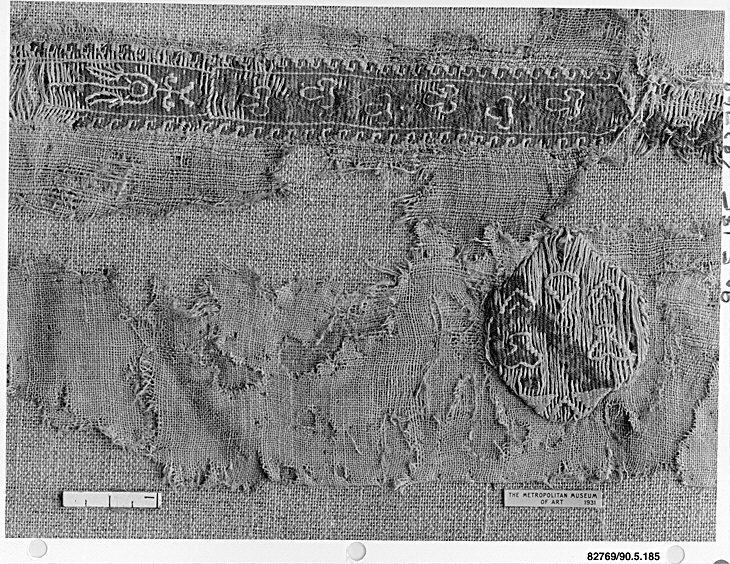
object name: textile fragment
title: Fragment of a Tunic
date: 401-500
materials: linen, wool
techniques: weave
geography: egypt